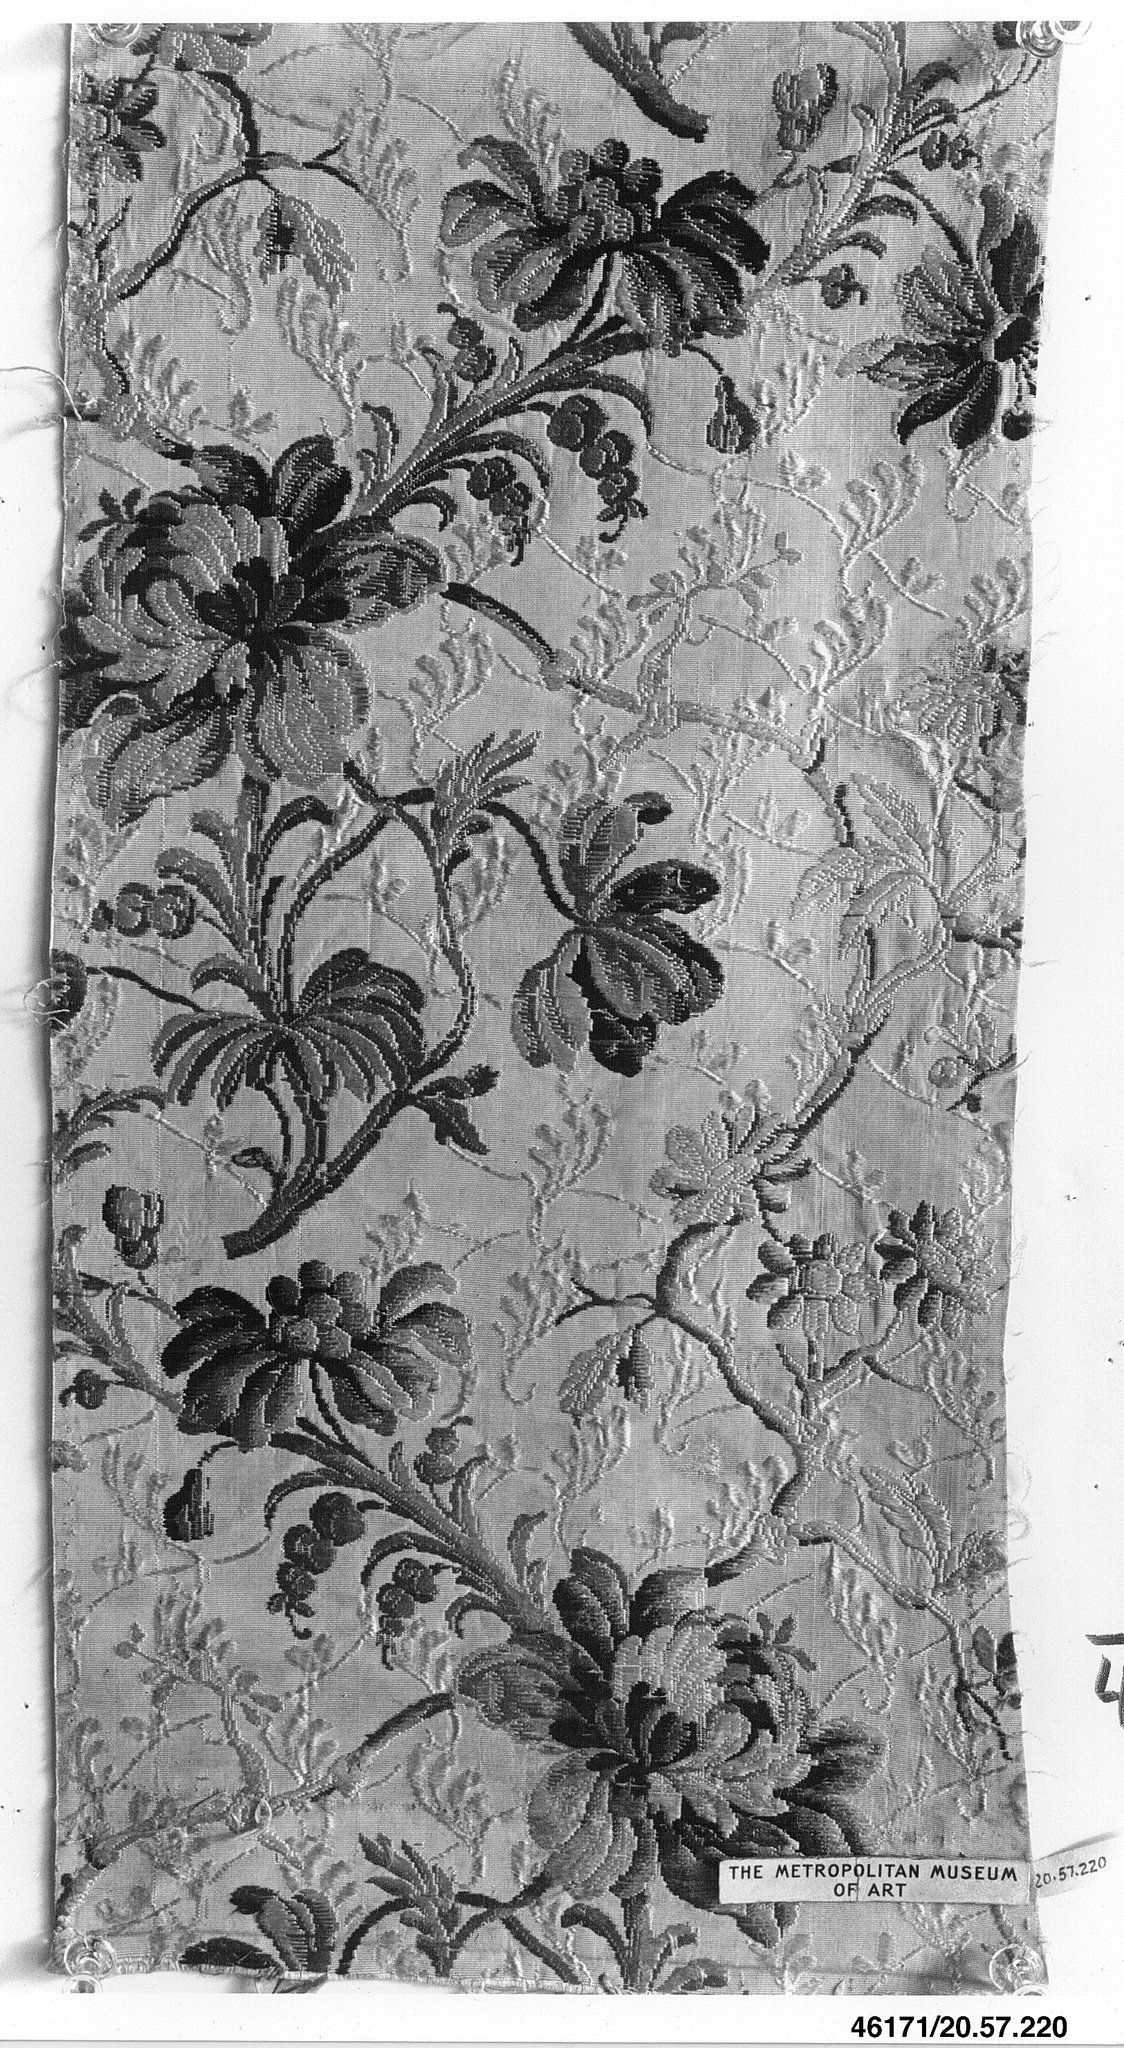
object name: piece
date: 1750-1760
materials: silk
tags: flowers,leaves